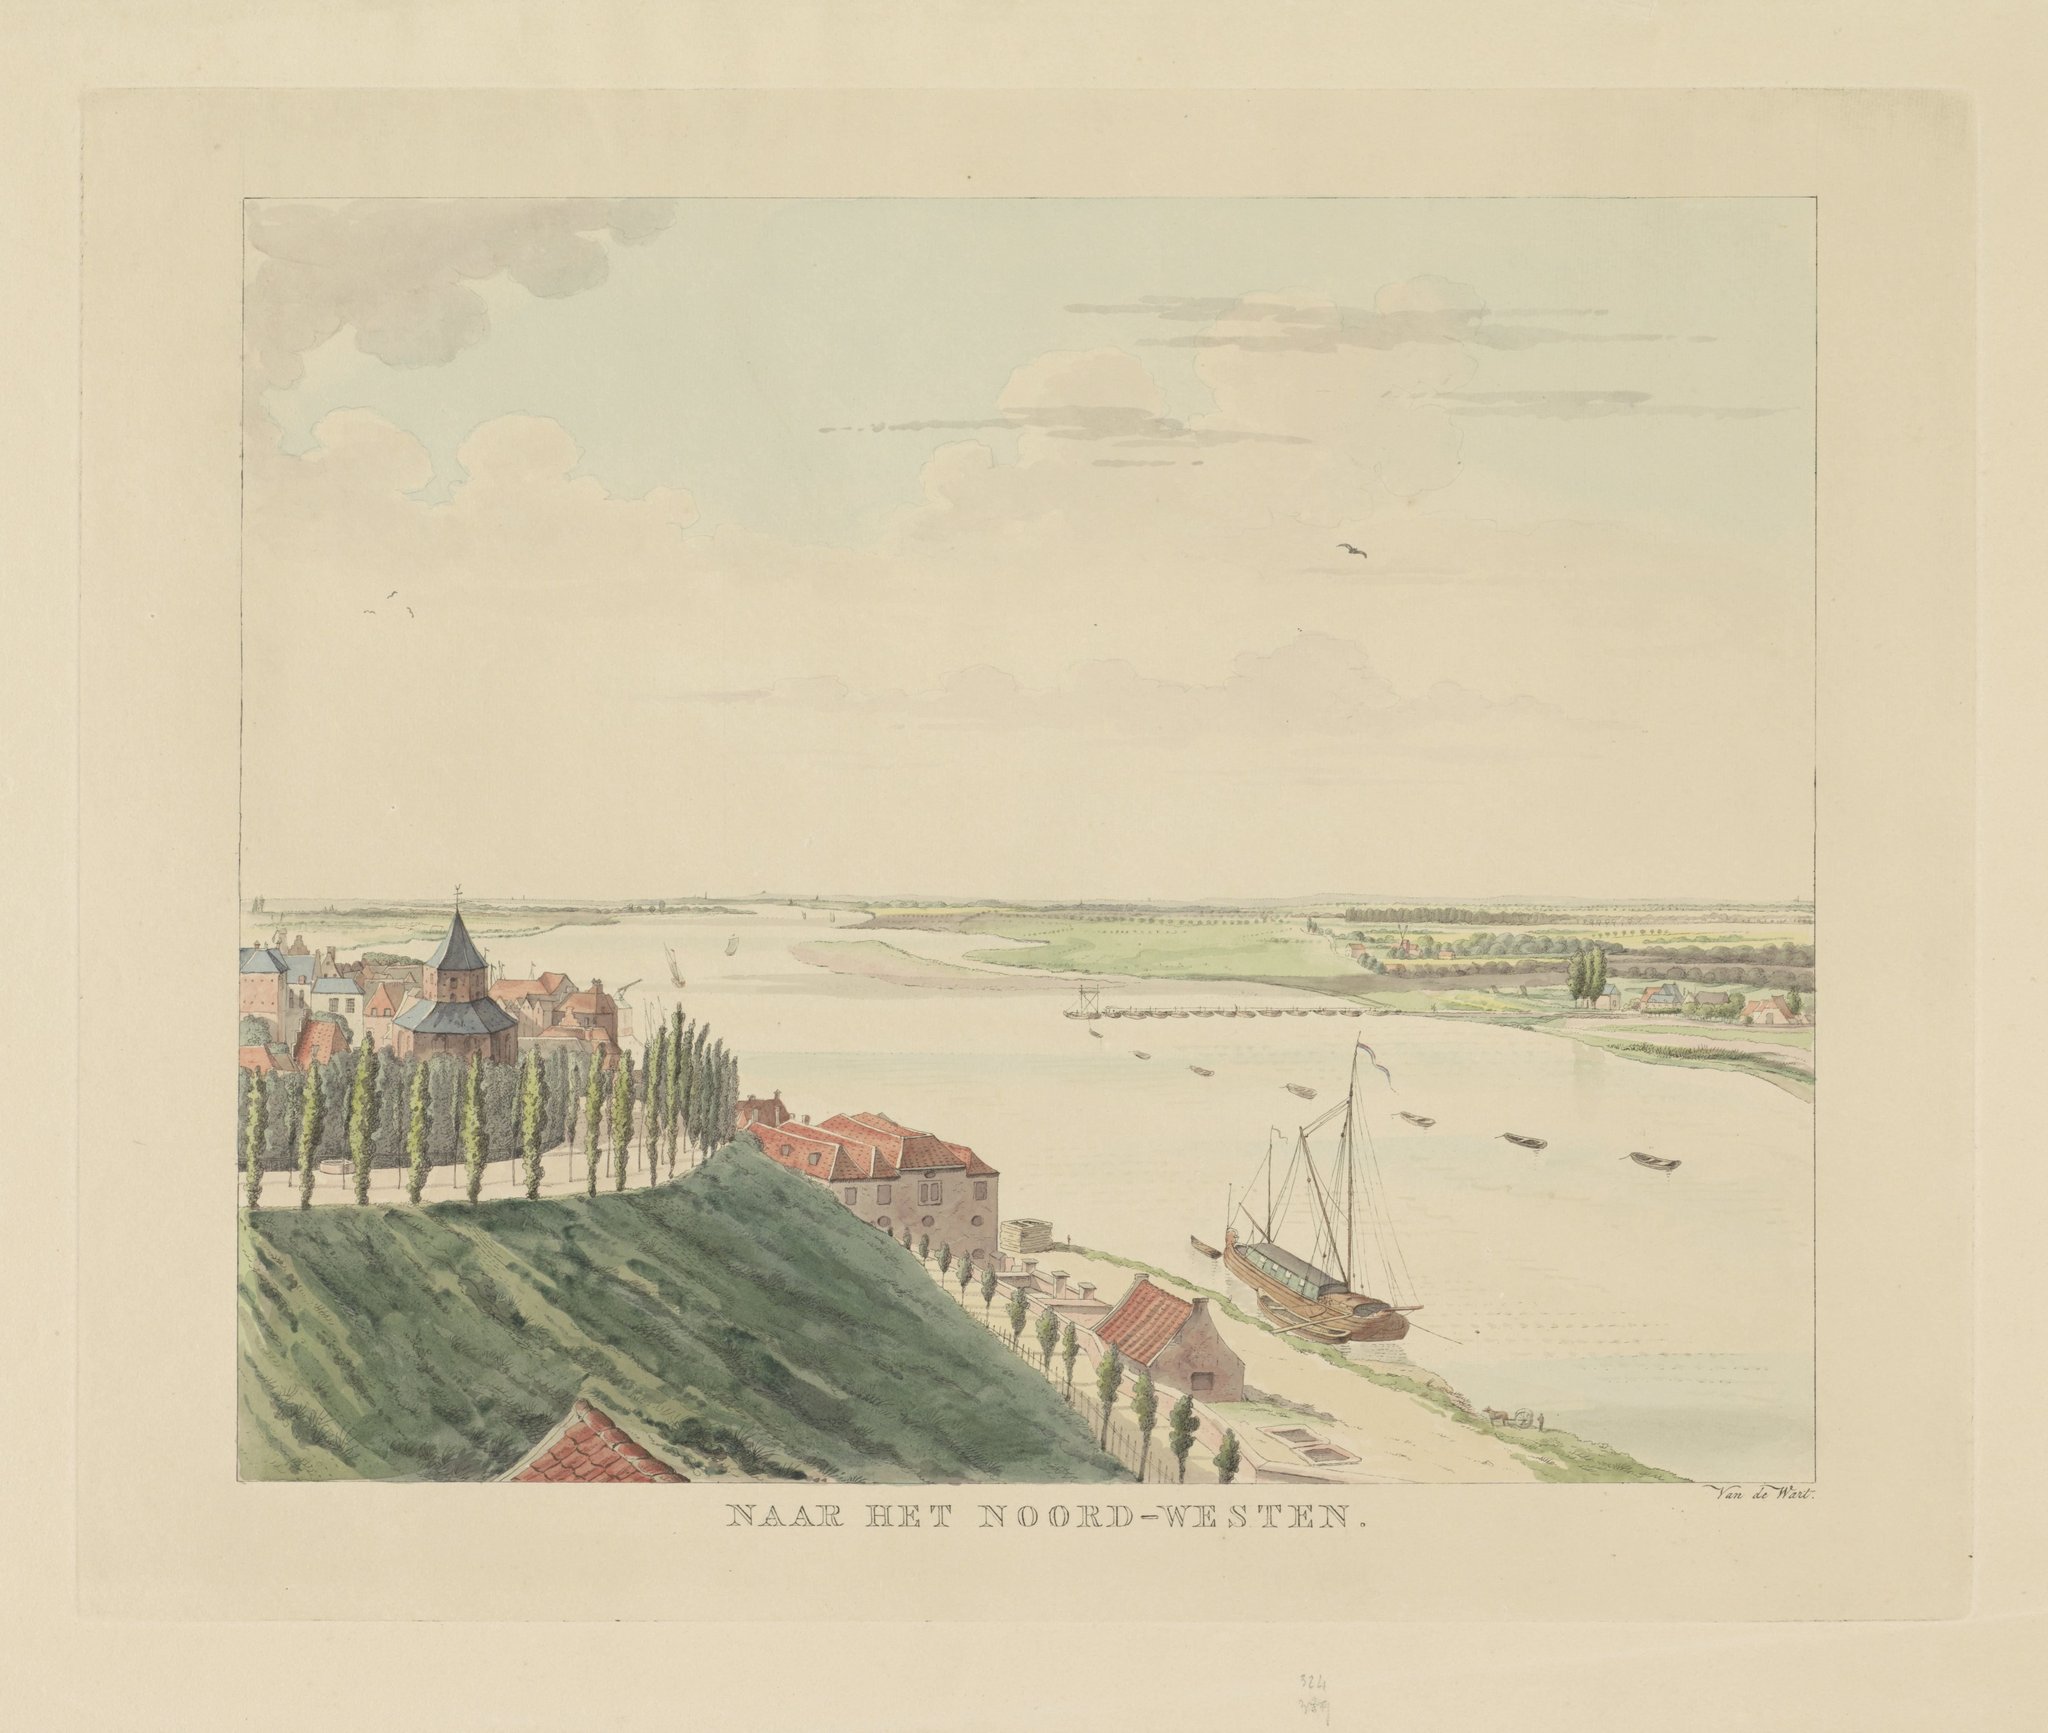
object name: print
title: Naar het noord-westen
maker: derk anthony van de wart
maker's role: draughtsman, painter, print maker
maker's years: 1767-1824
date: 1815-1824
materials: paper, watercolor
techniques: brush, etching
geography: nijmegen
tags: river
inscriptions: collector's mark: Lugt 2228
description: Rechts stroomt de Waal. Op de rivier varen enkele boten. Links ligt de Sint-Nicolaaskapel op het Valkhof. De prent is een onderdeel van een suite van negen prenten, inclusief de titelprent.